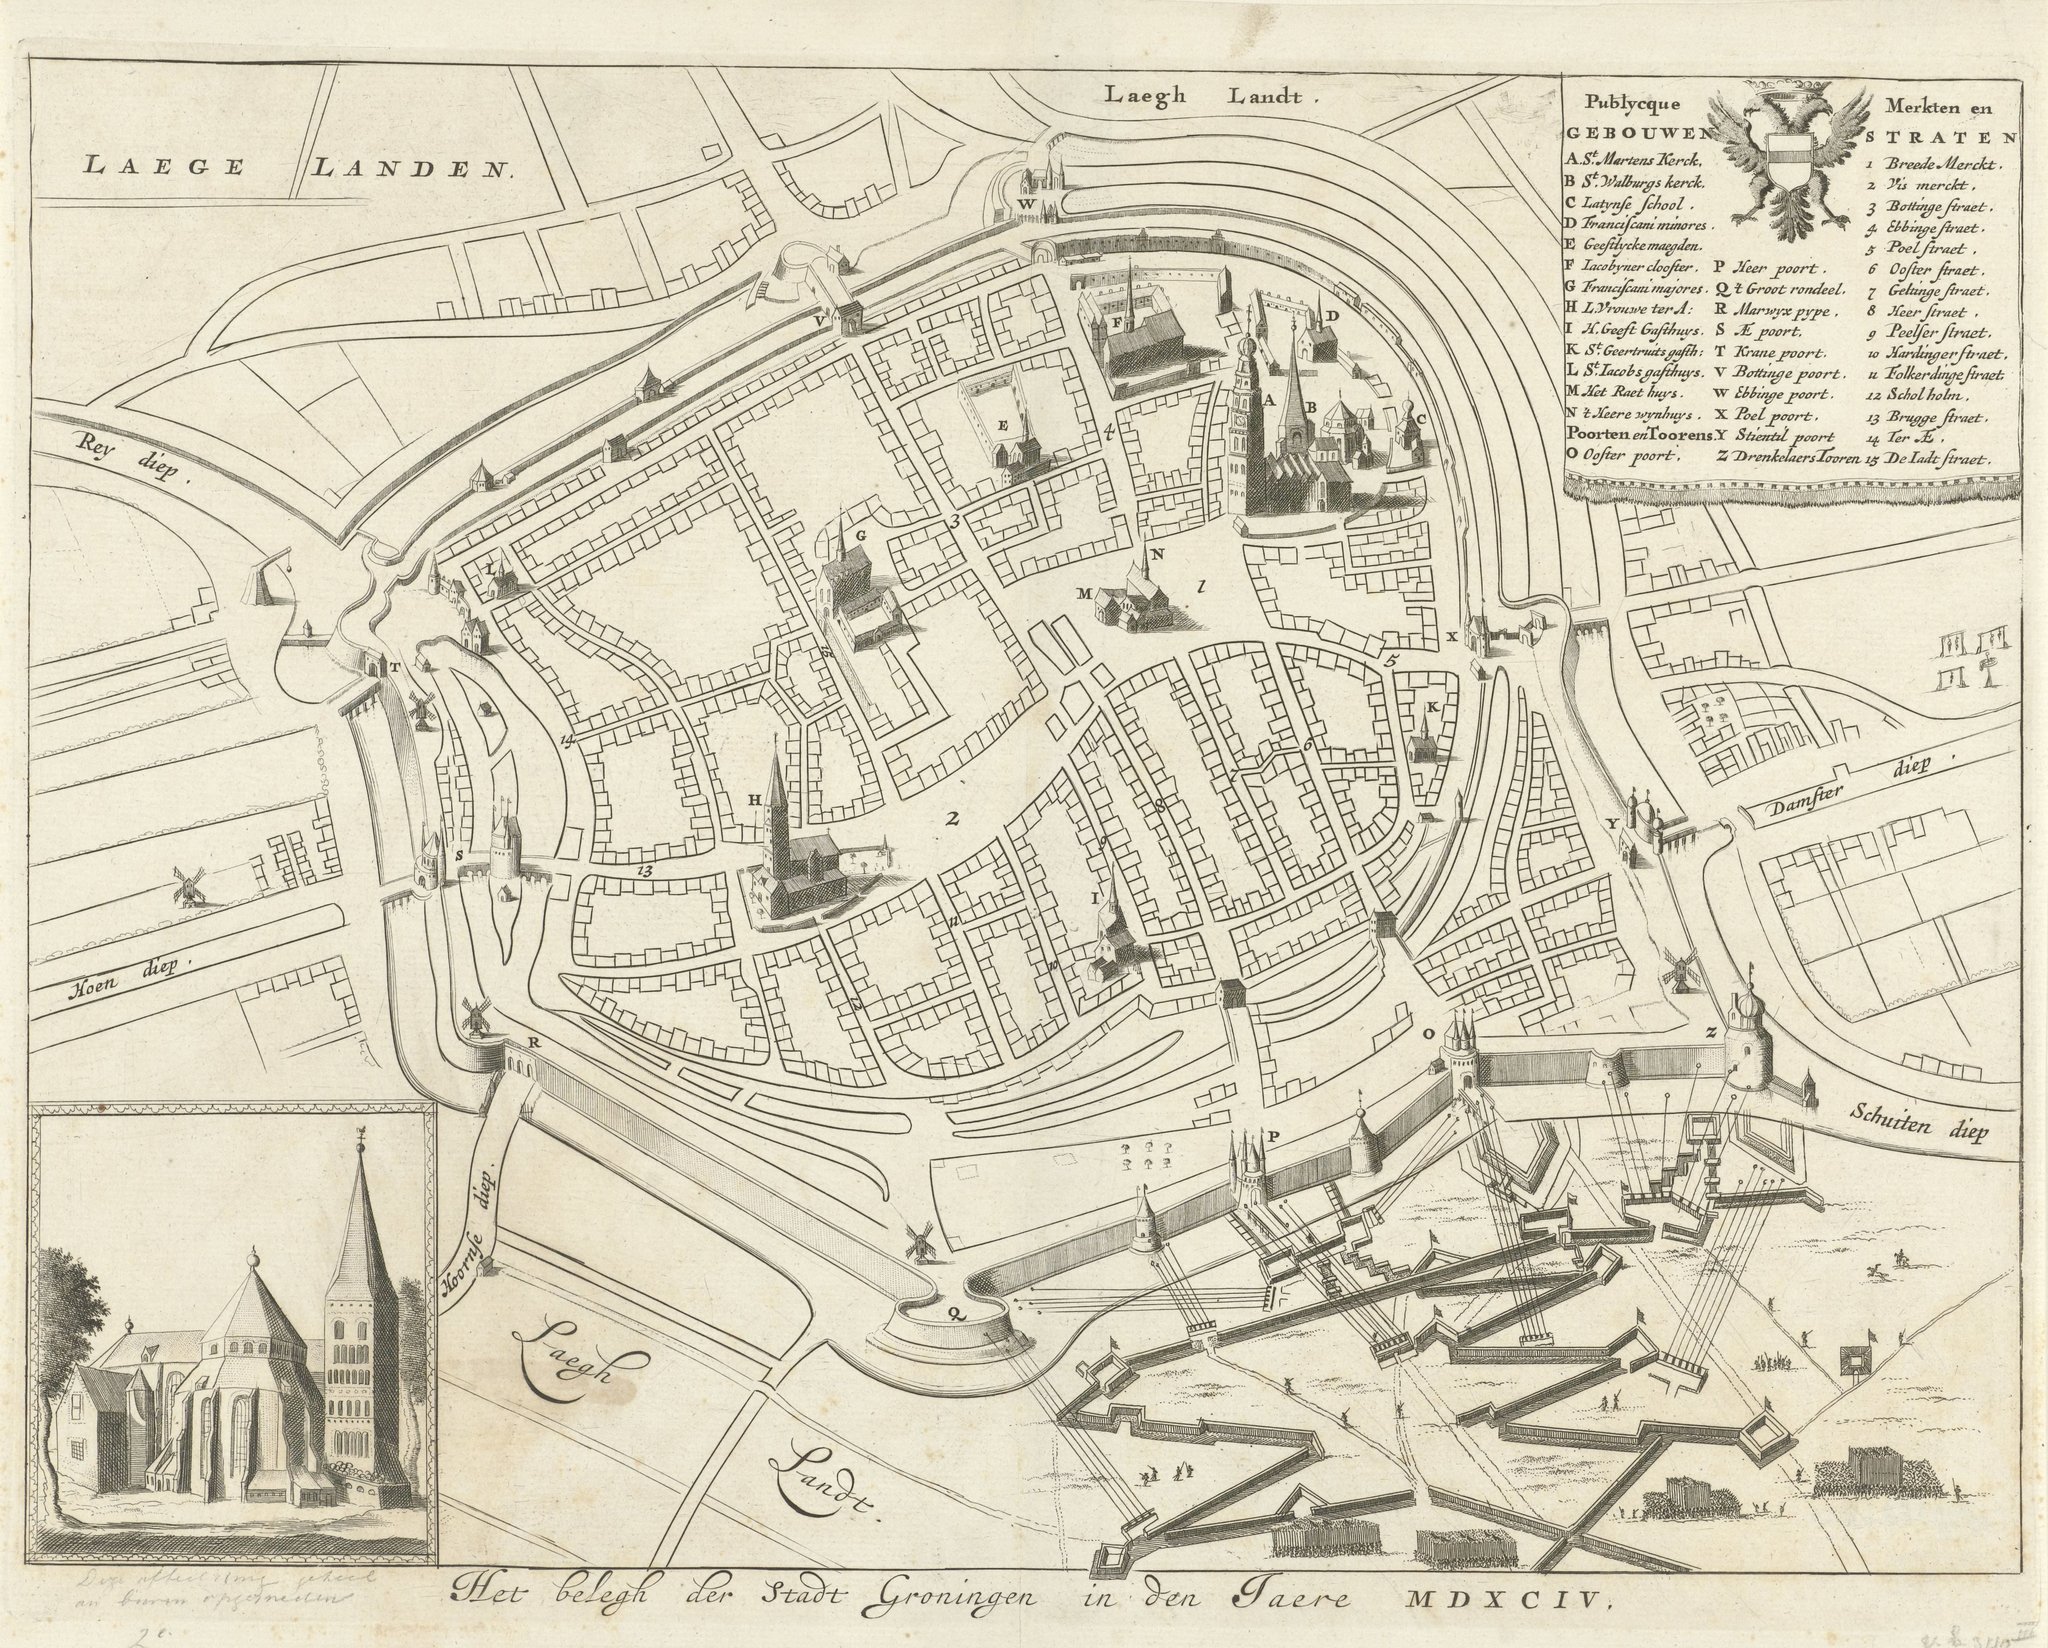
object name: area plan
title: Plattegrond van de stad Groningen tijdens het beleg van 1594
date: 1681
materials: paper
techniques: engraving, etching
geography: amsterdam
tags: coat of arms (as symbol of the state, etc.), siege, position war, maps of cities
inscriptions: collector's mark: Lugt 2228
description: Plattegrond in vogelvluchtperspectief van Groningen tijdens het beleg door het Staatse leger onder Maurits in 1594. Onderaan de loopgraven en wallen van het leger van de prins. Linksonder een afbeelding van de Sint Walburgskerk, rechtsboven het wapen van de stad en de legenda A-Z en 1-15 in het Nederlands.